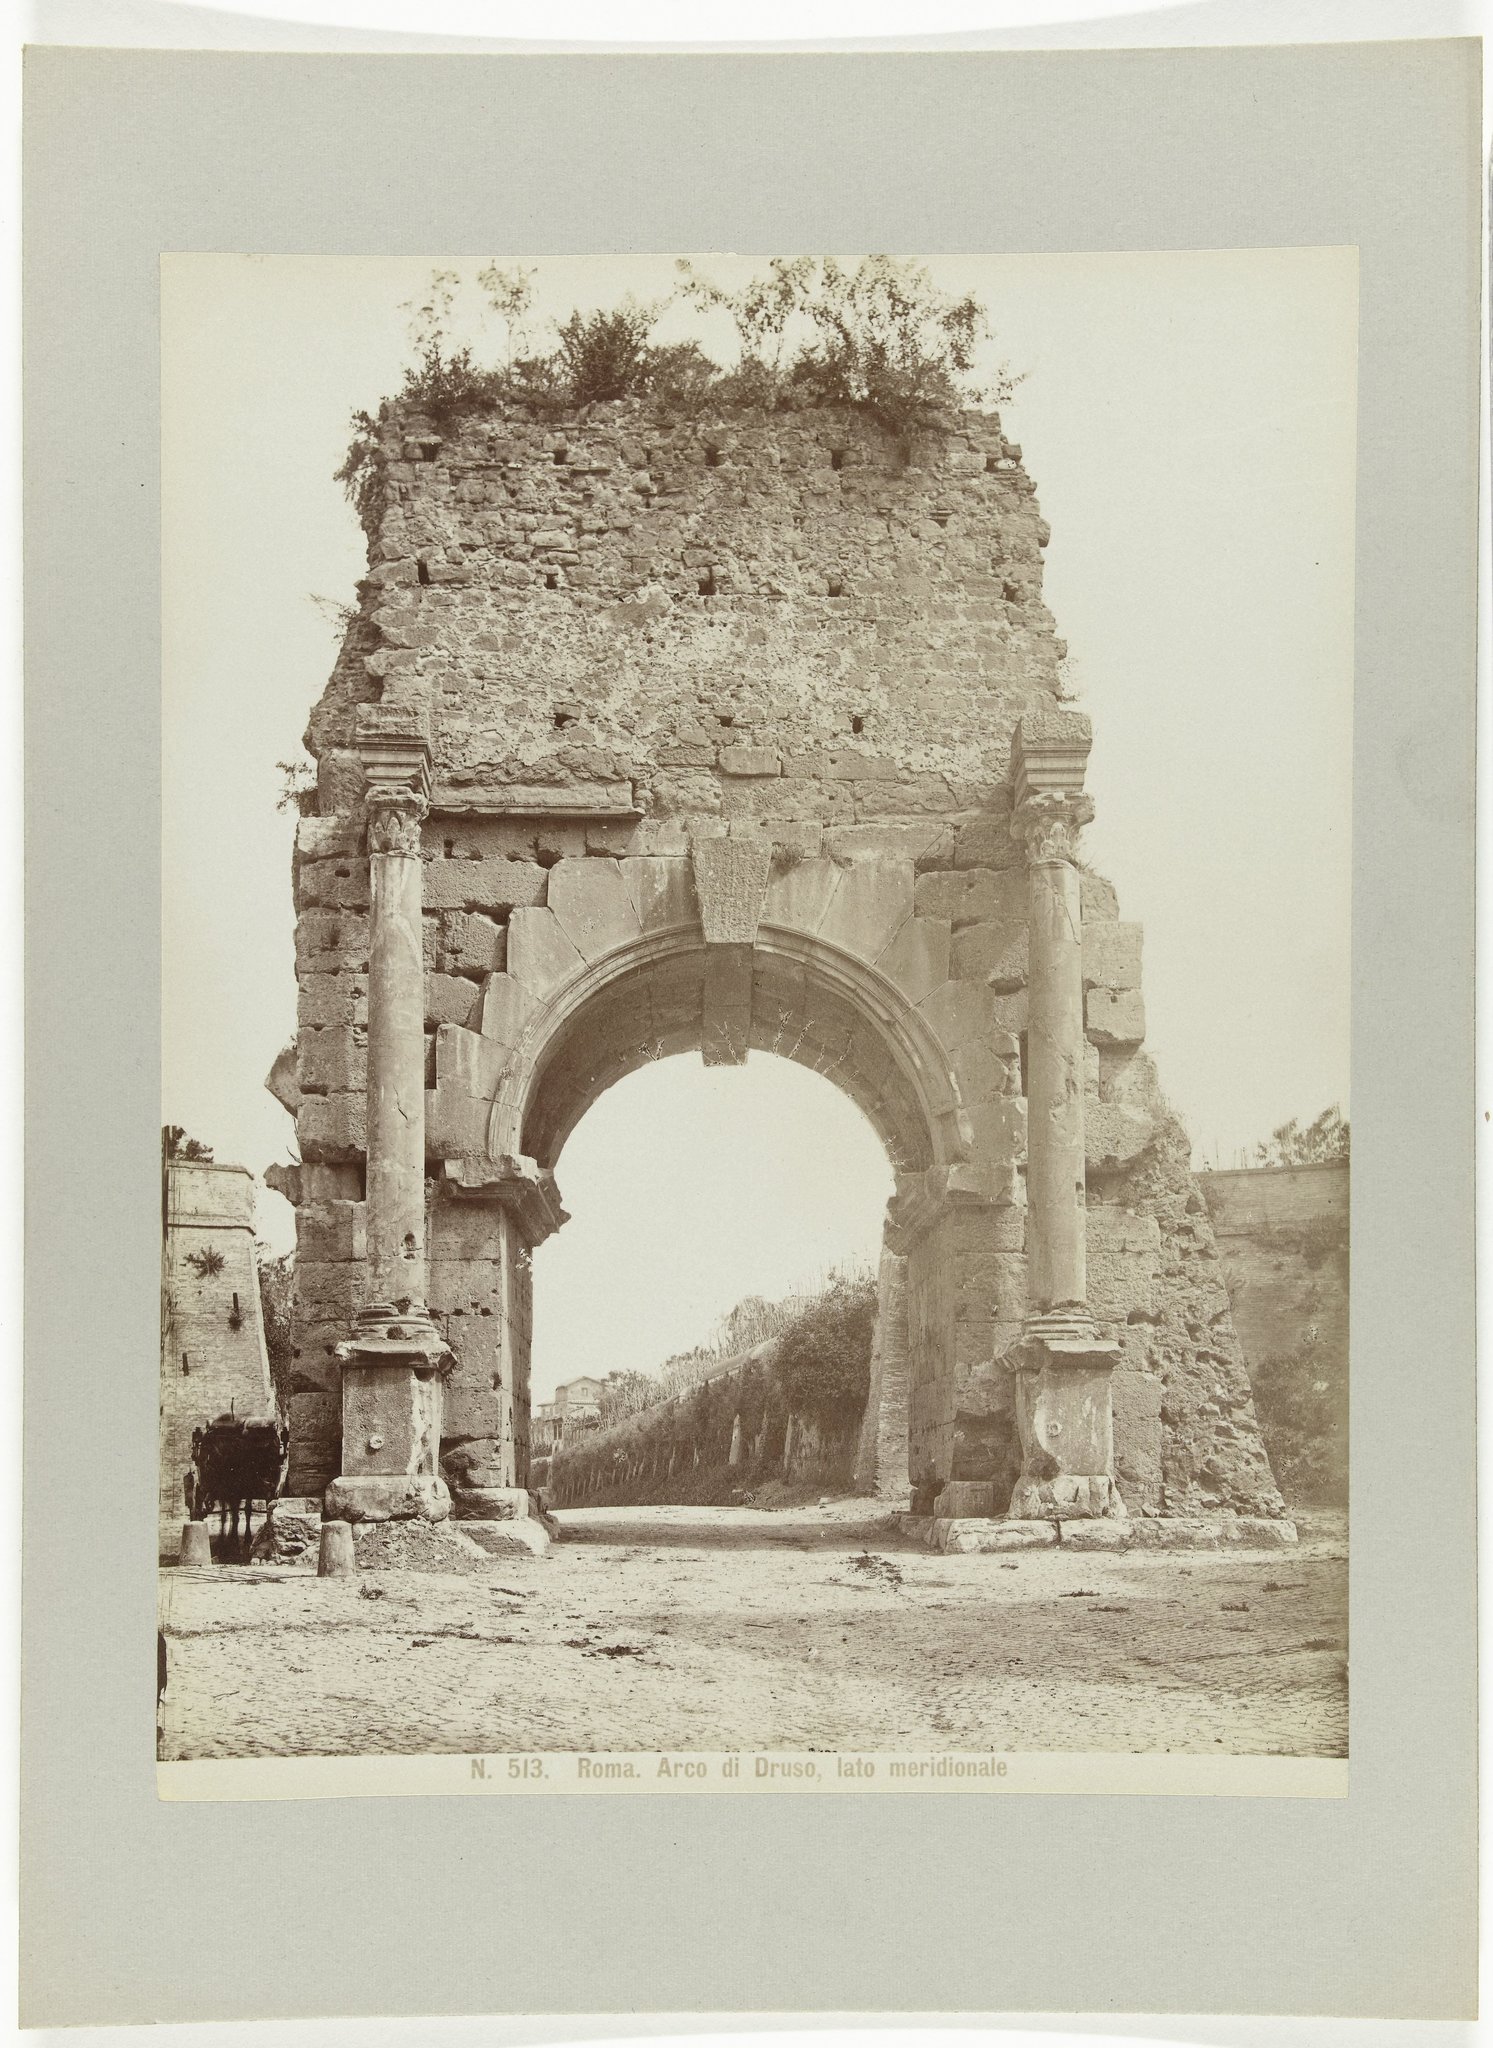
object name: photograph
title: Boog van Druso te Rome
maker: Anonymous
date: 1880-1904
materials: cardboard, paper, photographic support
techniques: albumen print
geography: rome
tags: rome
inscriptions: number: ‘26.’